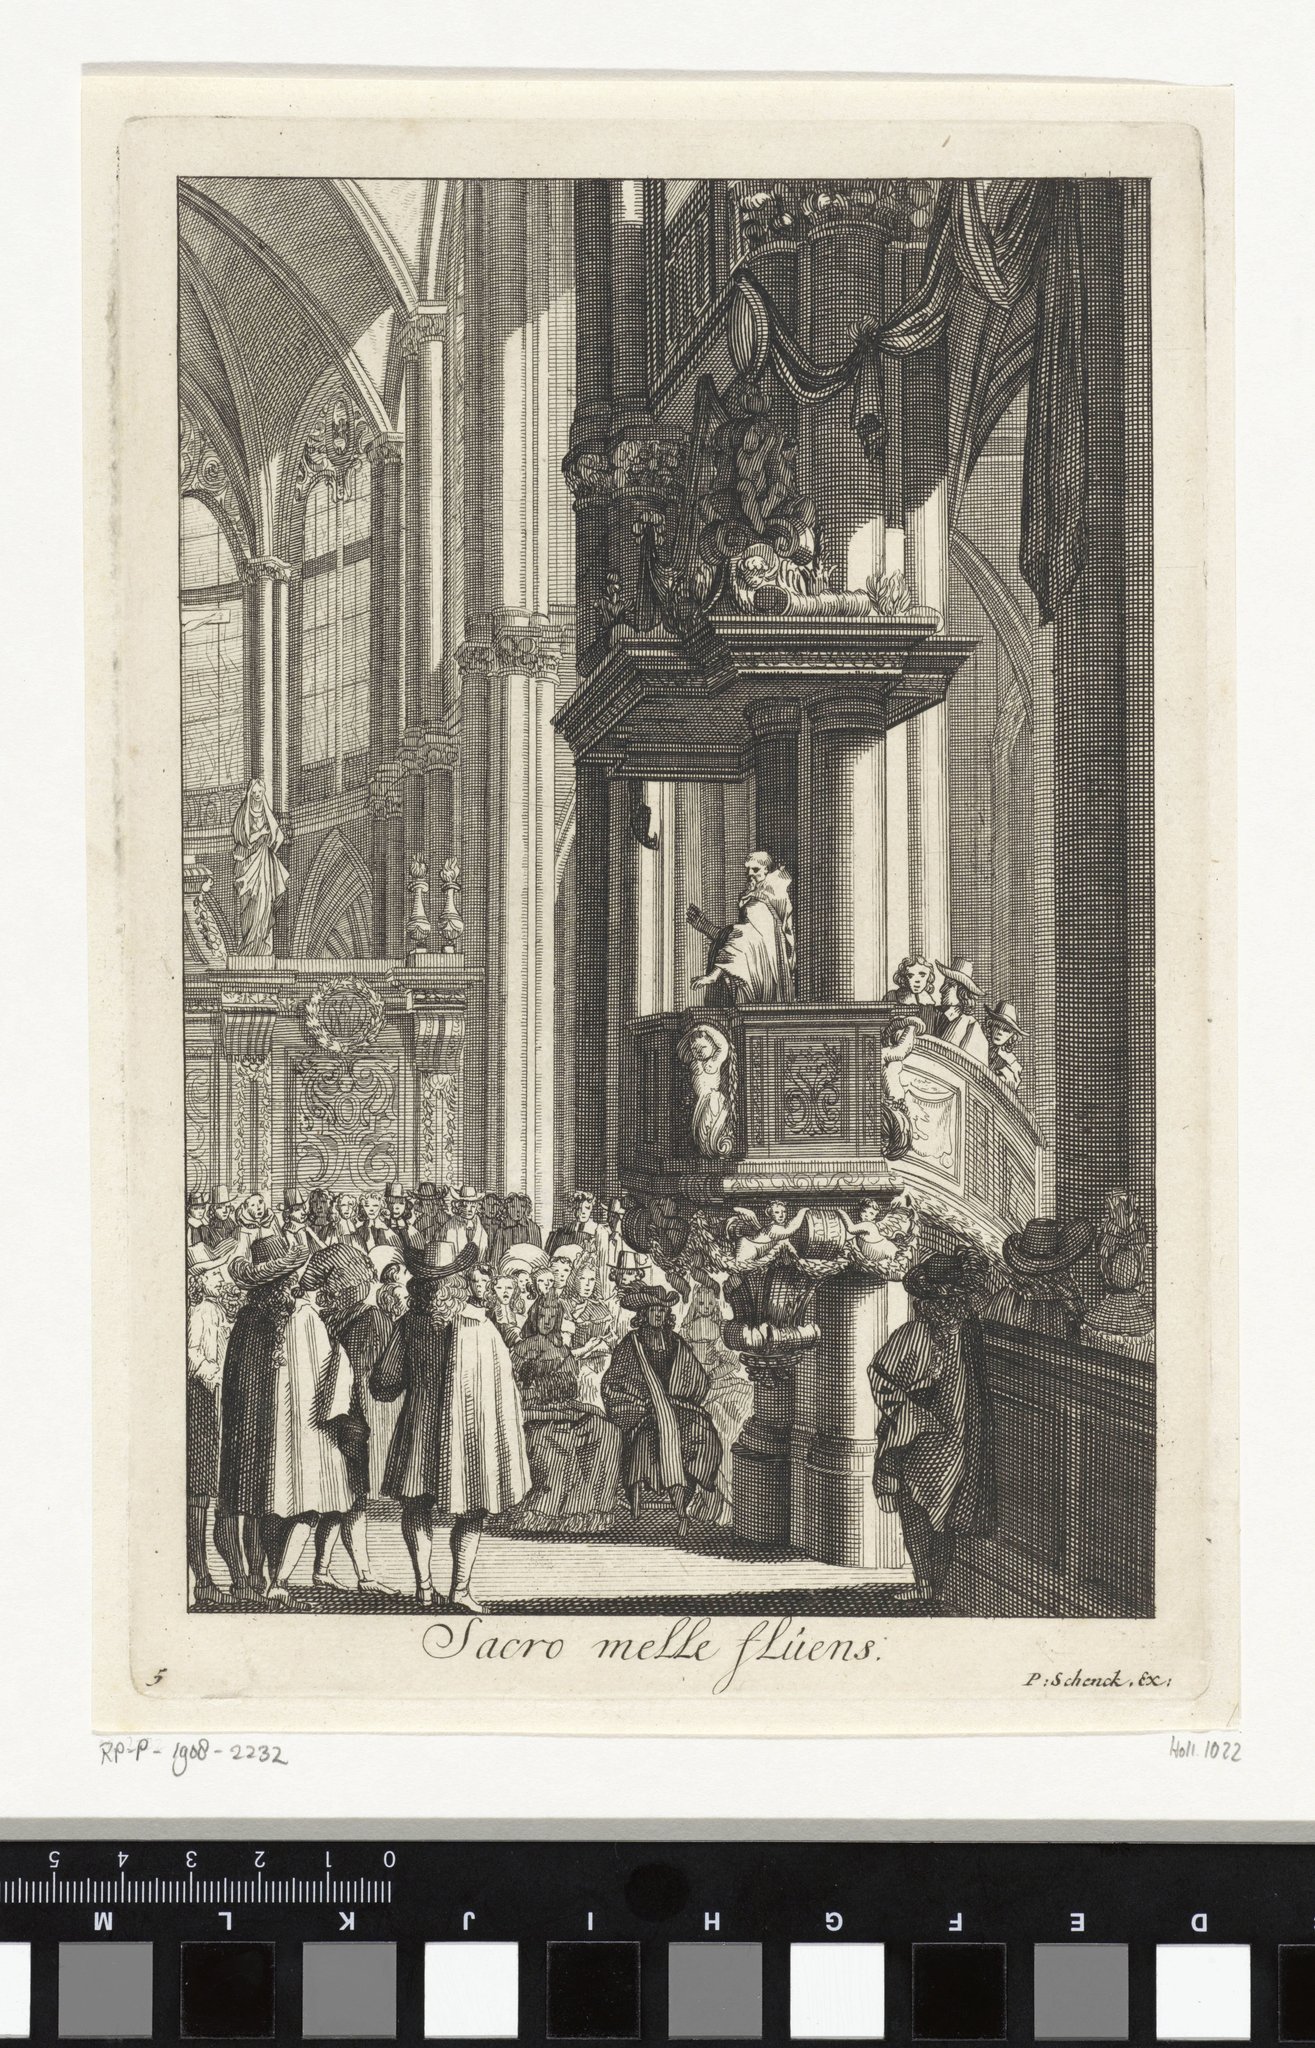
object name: print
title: Sacro melle flúens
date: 1675-1711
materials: paper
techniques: engraving, etching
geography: amsterdam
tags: pulpit, ambo, chancel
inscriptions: collector's mark: Lugt 2228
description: Een prediker staat rechts op een preekstoel of kansel. Achter hem staan drie mannen op de trap naar de preekstoel. De kerk is gevuld met toehoorders, die deels staan en deels zitten.